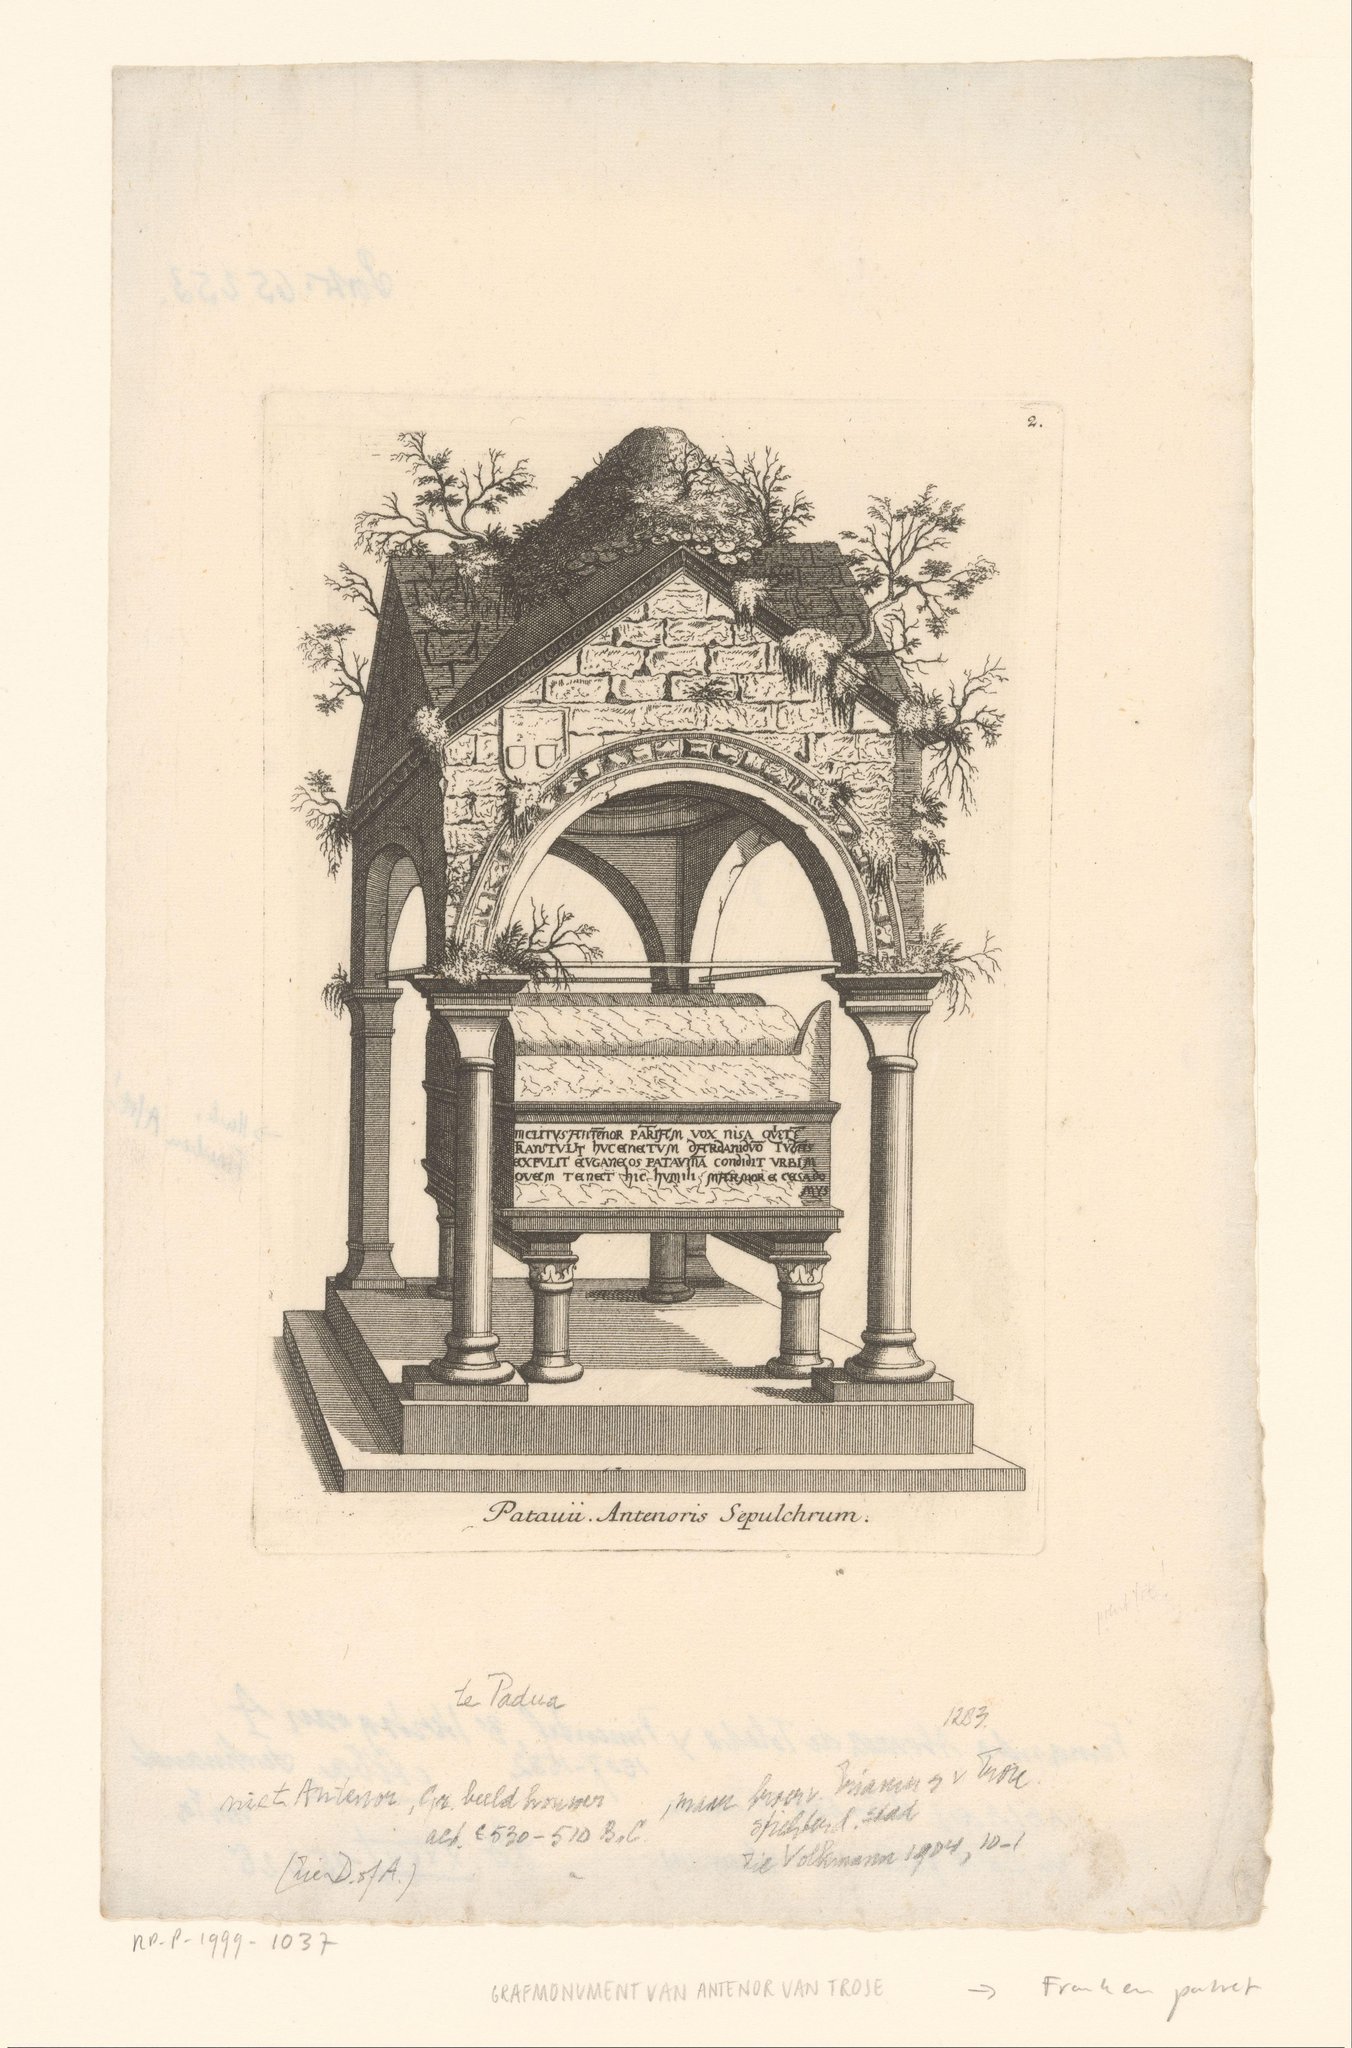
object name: print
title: Patavii Antenoris Sepulchrum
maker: Anonymous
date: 1700-1800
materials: paper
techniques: etching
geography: italy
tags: grave-building, monumental tomb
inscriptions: collector's mark: Lugt 2760, collector's mark: Lugt 2228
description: Grafmonument met zogenaamd de resten van de legendarische stichter van de stad Padua. Rechtsboven genummerd: 2.